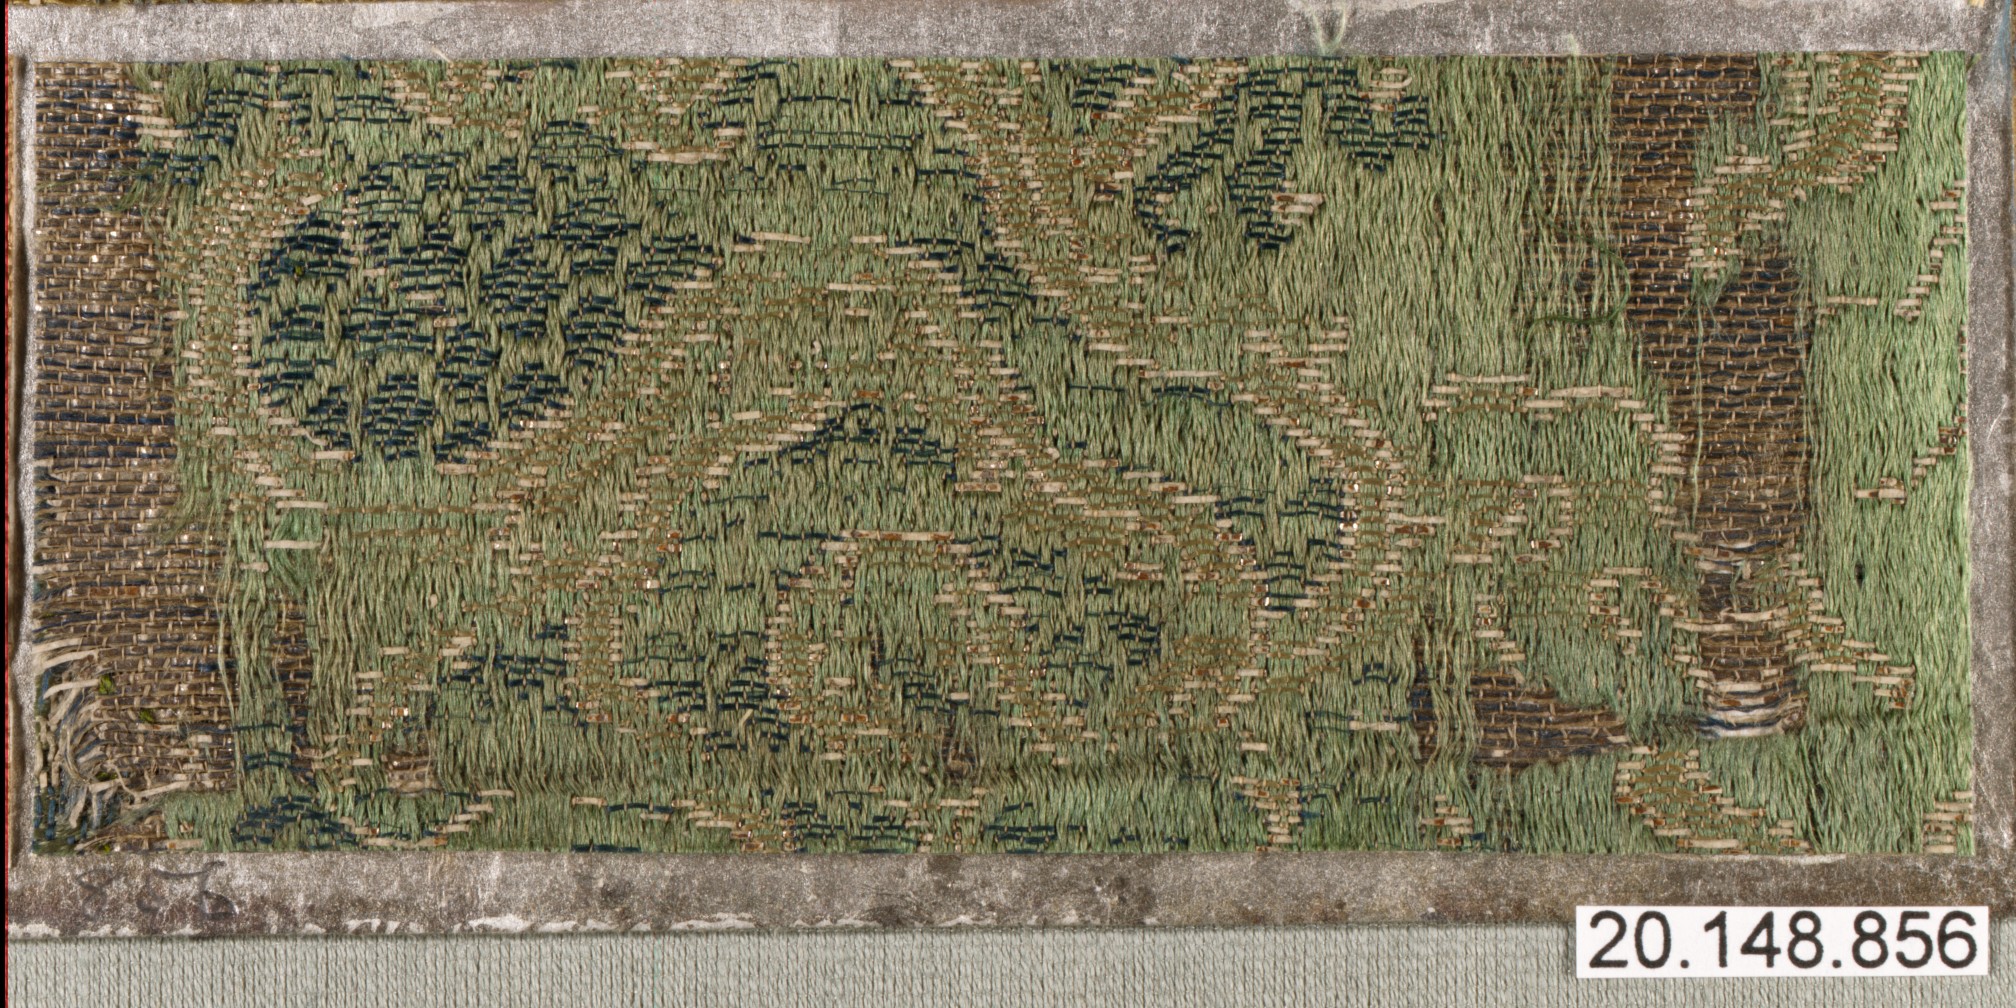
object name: piece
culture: japanese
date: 1701-1800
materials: silk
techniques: compound weave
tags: dragons